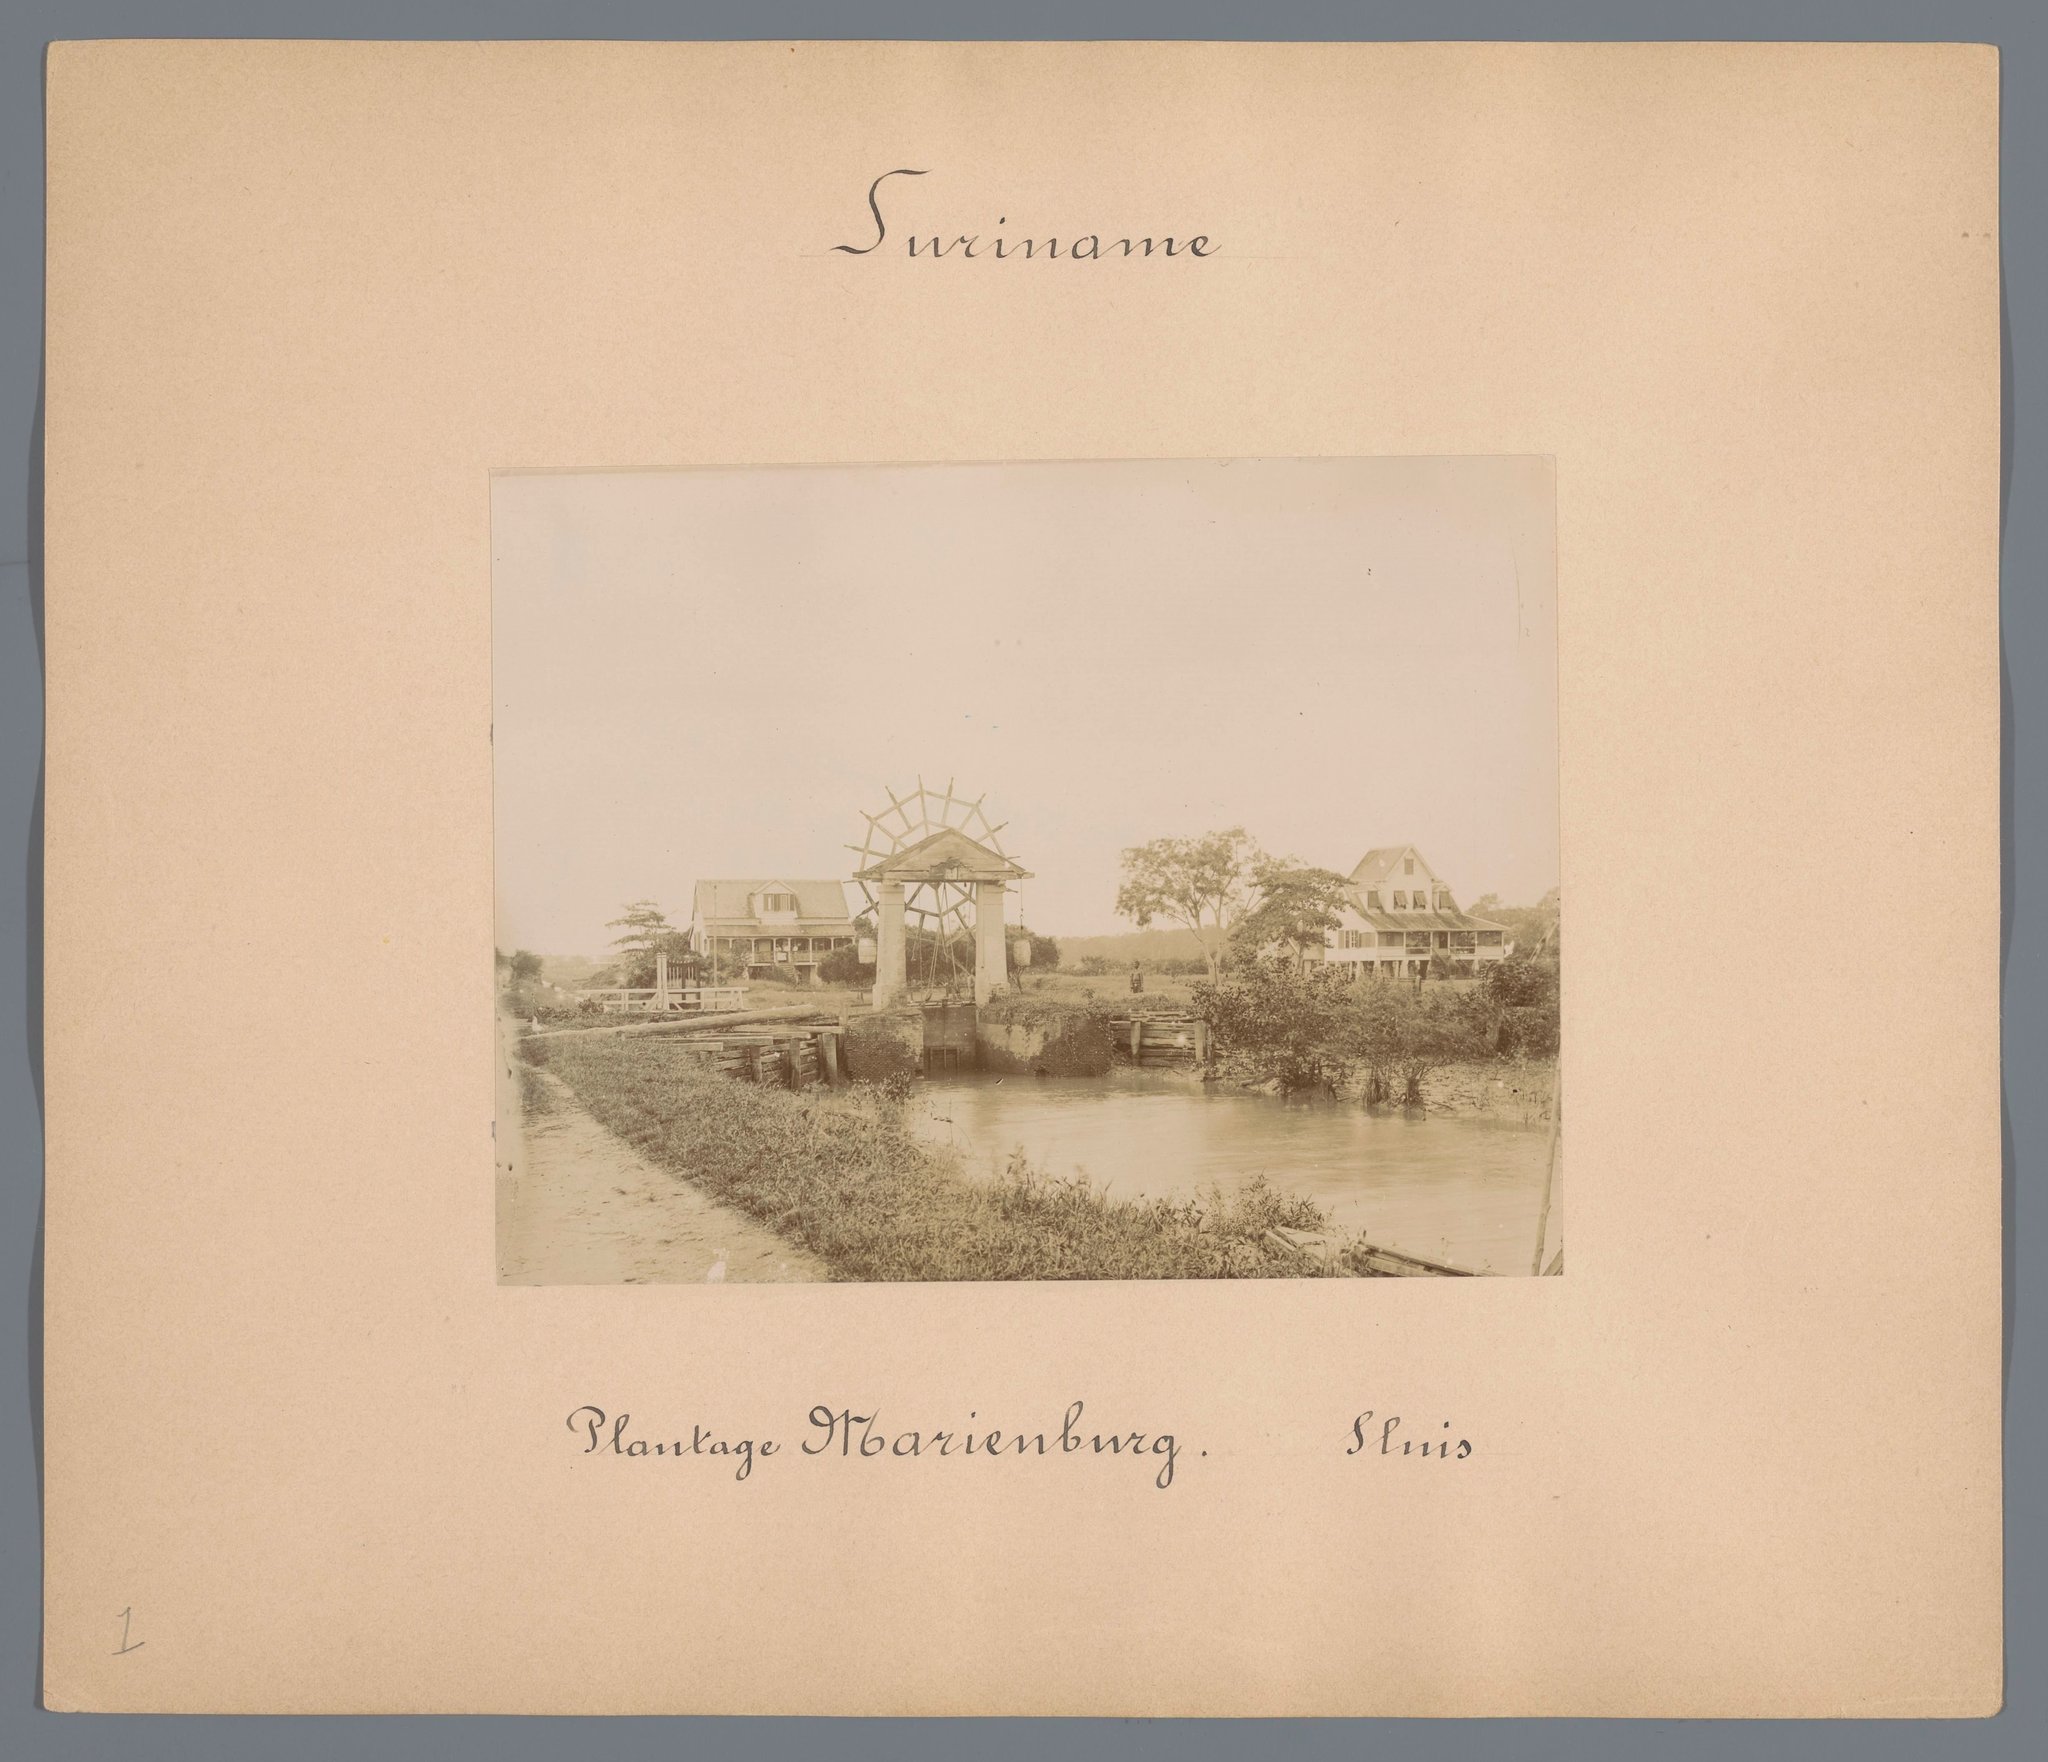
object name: photograph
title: Plantage Marienburg. Sluis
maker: eugen klein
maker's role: fotograaf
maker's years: 1869-1927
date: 1900-1905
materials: cardboard, photographic support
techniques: gelatin silver print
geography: suriname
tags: suriname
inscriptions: inscription: ‘Suriname / Plantage Marienburg. Sluis’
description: De sluis en enkele plantagewoningen op de plantage Mariënburg in Suriname. Onderdeel van een groep van 44 foto's van Paramaribo, Suriname en Curaçao, ca. 1900-1905, opgeplakt op kartons en voorzien van opschriften.